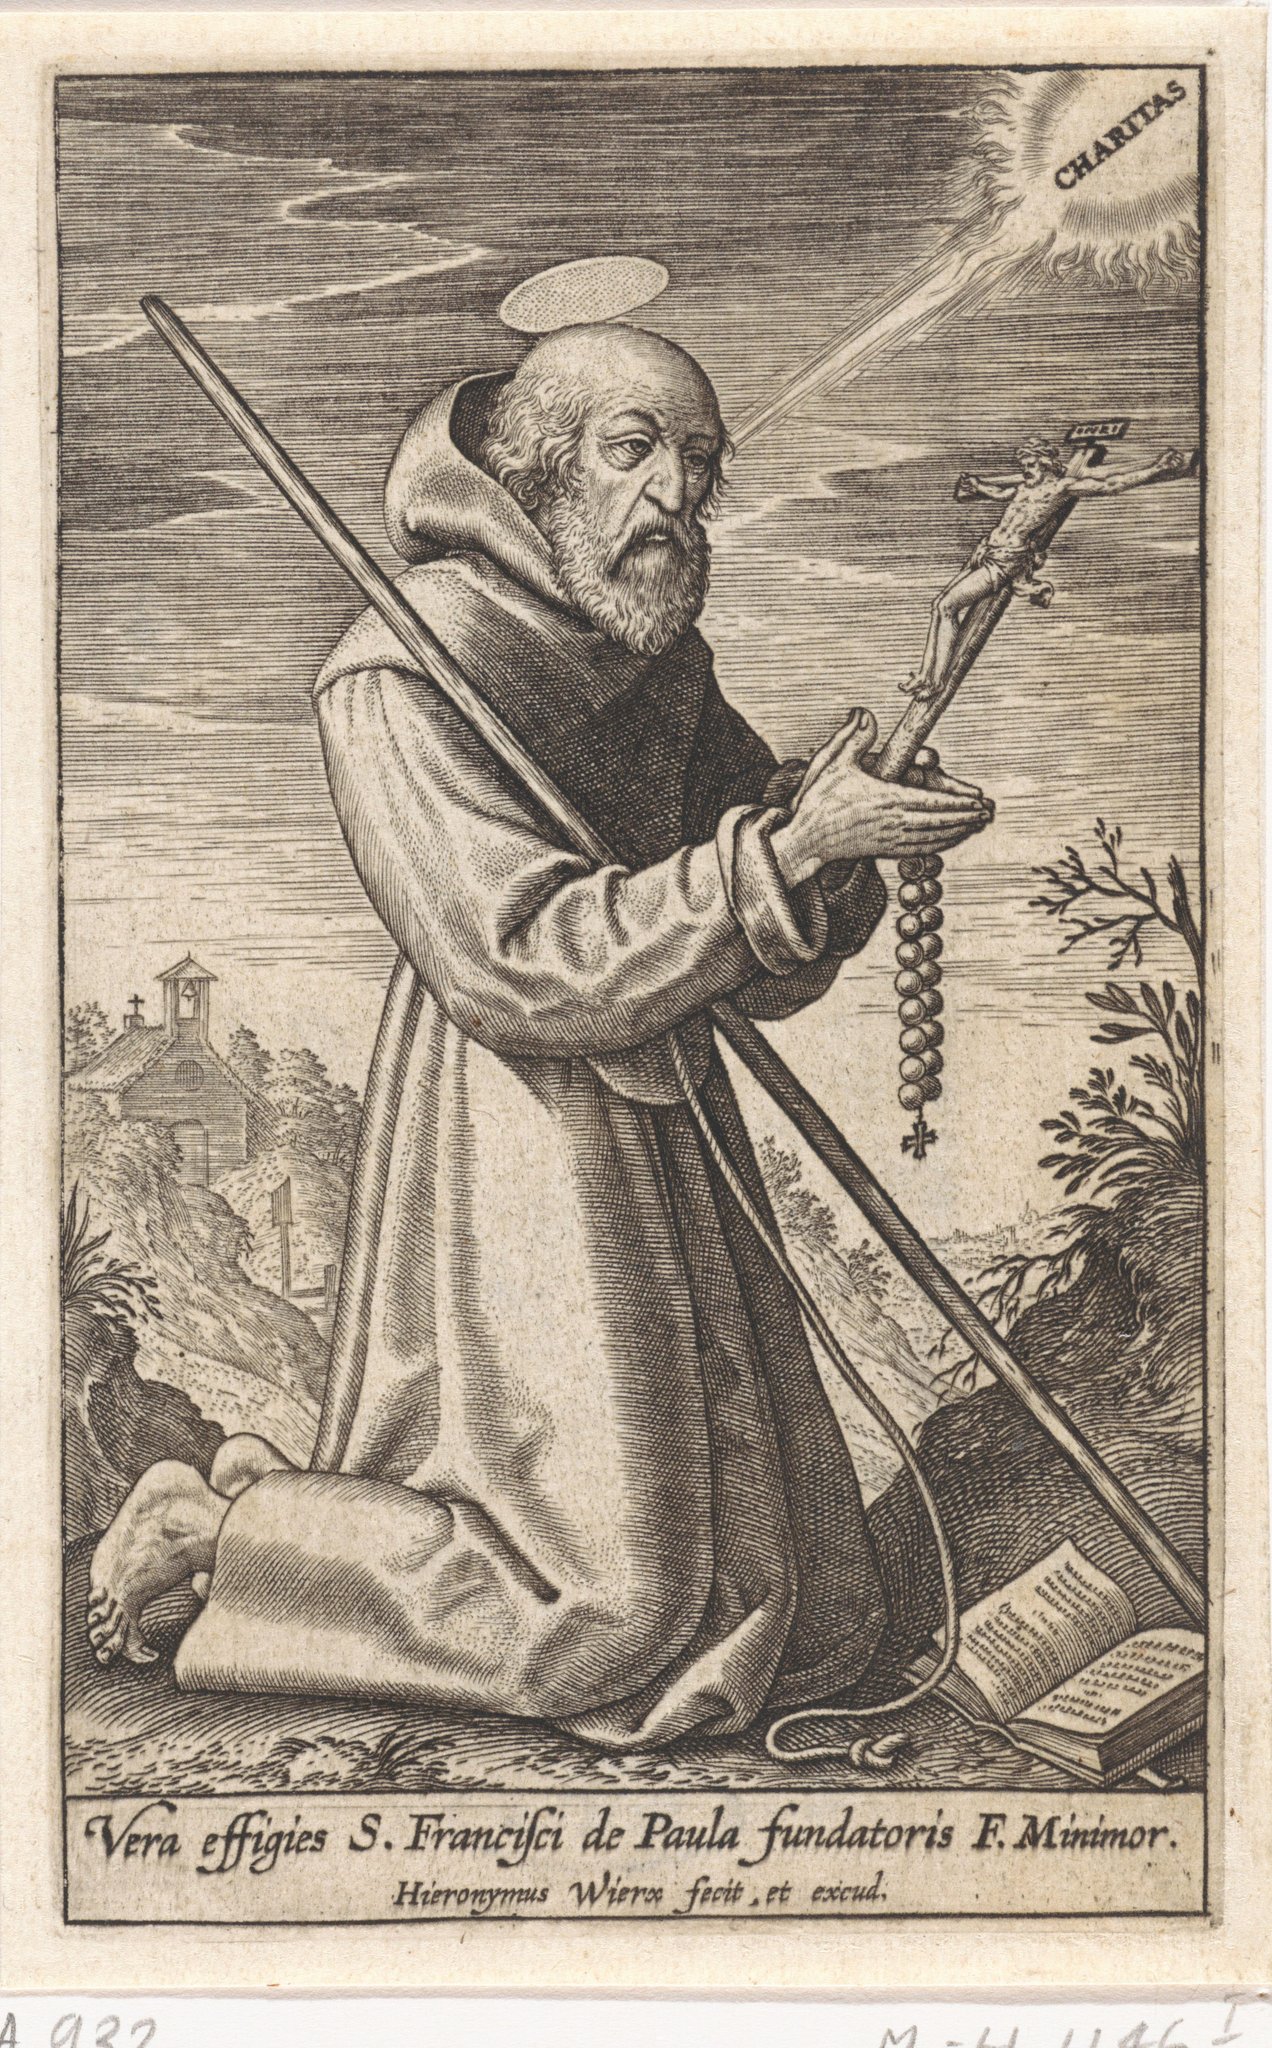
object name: print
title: Landschap met de H. Franciscus van Paola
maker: hieronymus wierix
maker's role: draughtsman, print maker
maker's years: 1553-1619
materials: paper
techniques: engraving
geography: antwerp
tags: one or more angels appear to st. francis of paola holding a tablet with the inscription 'charitas' (+ variant)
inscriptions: collector's mark: Lugt 2228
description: De heilige Franciscus van Paola zit geknield voor een opengeslagen boek, met een crucifix en een rozenkrans in zijn gevouwen handen. Vanuit de hemel wordt hij beschenen door stralen waarin het woord "Charitas" is opgenomen. Op de achtergrond een kerk. In de marge een onderschrift in het Latijn.